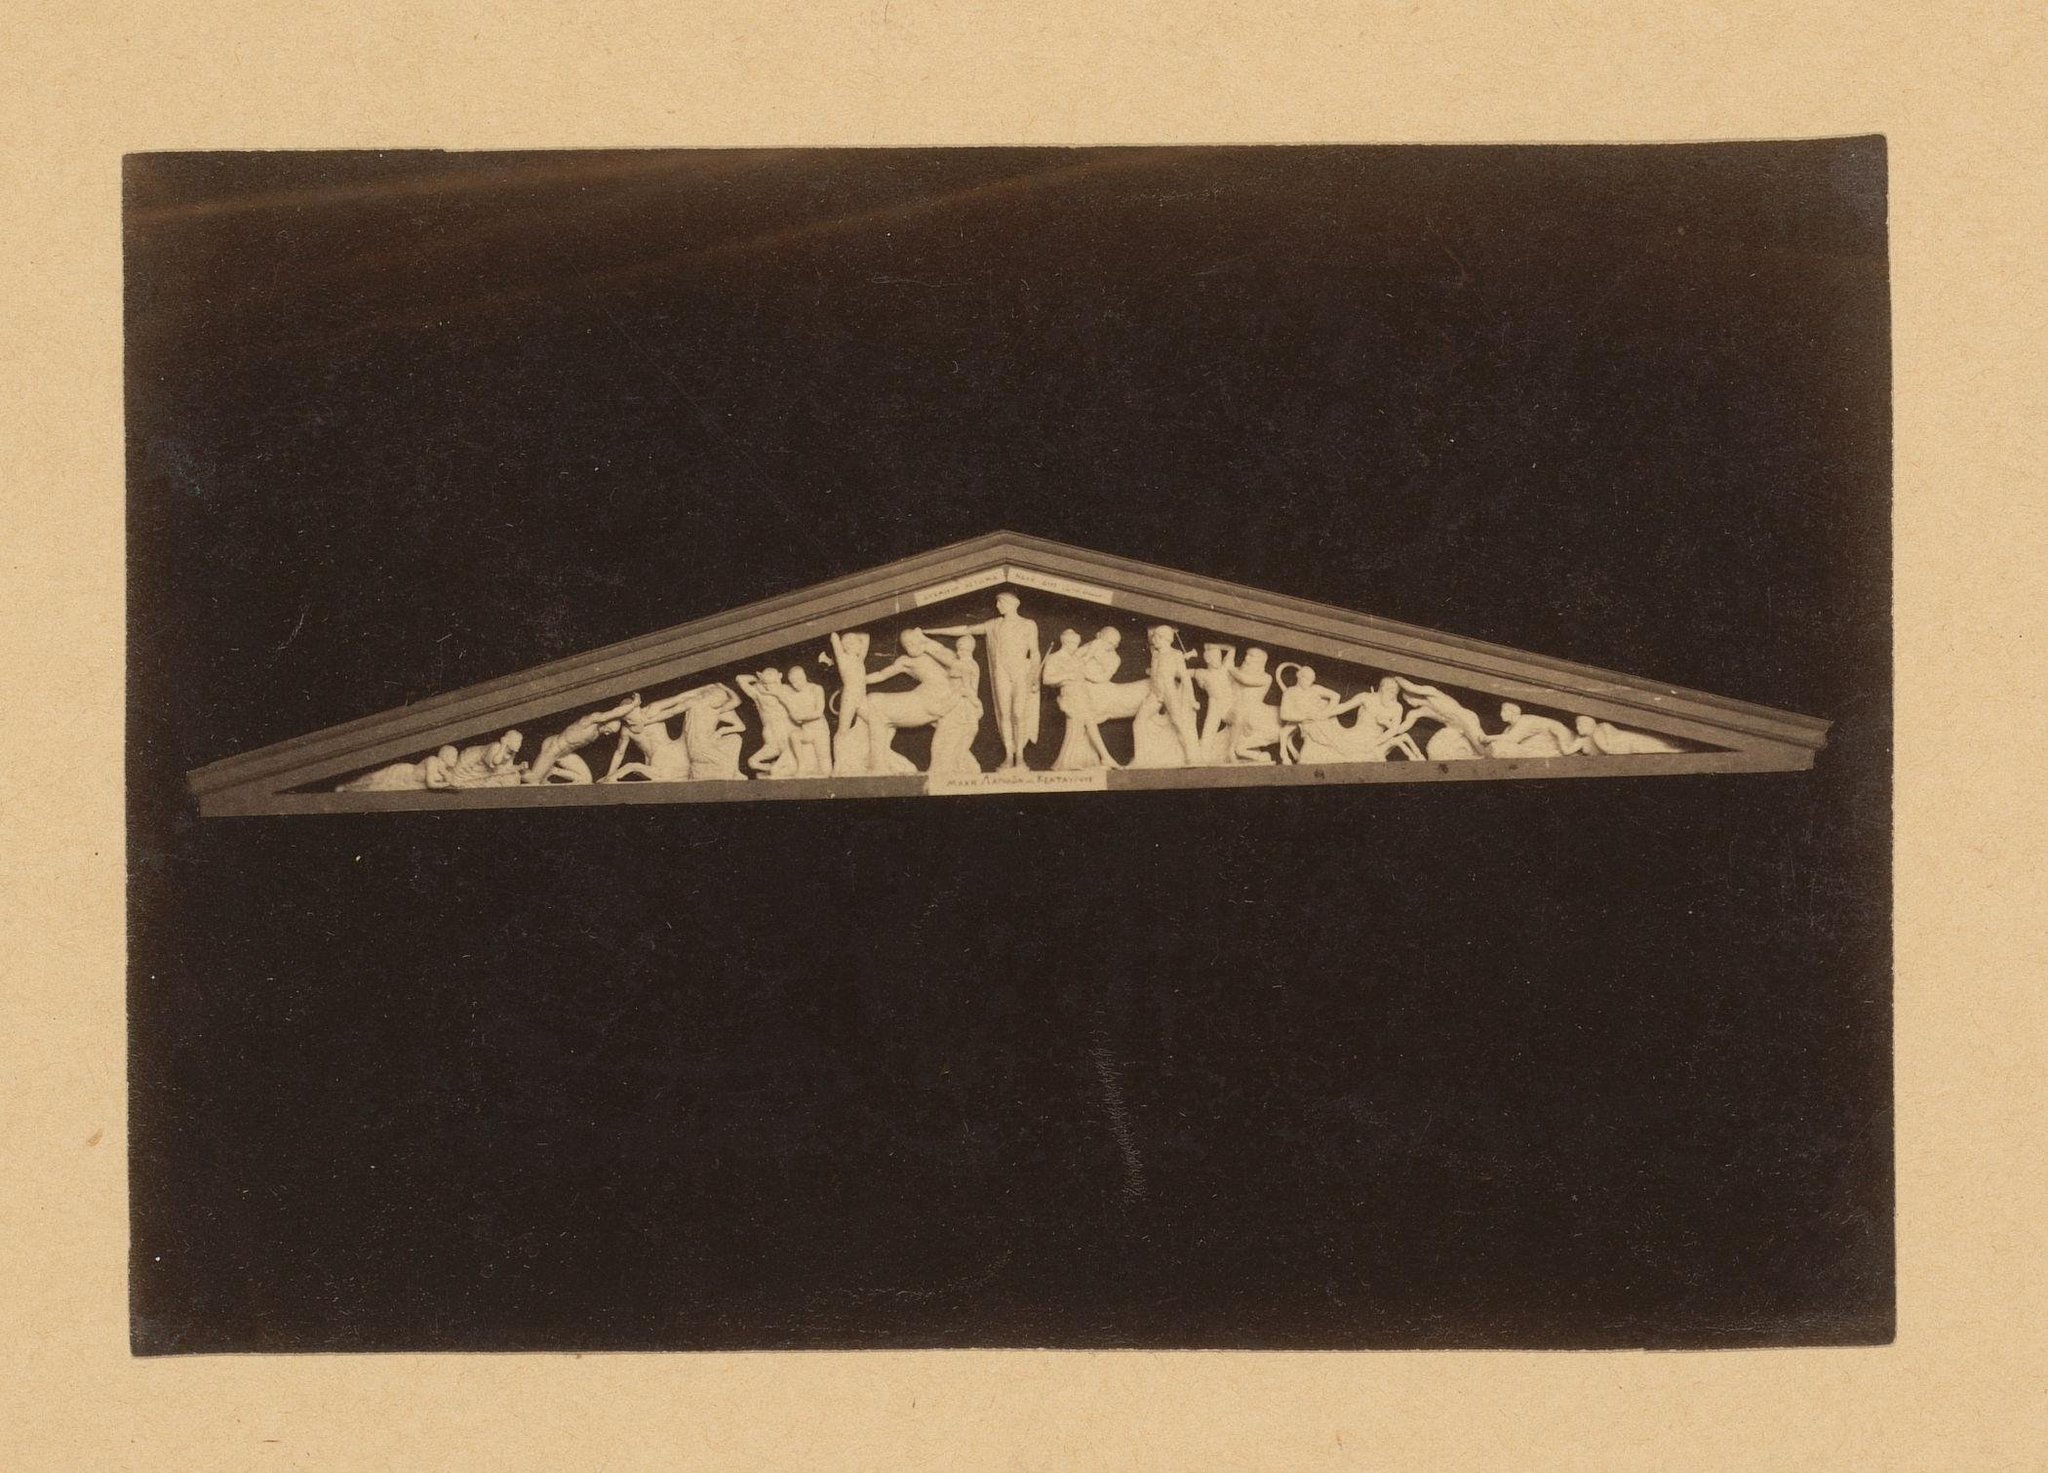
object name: photograph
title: Model van het timpaan van de tempel van Zeus te Olympia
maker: Anonymous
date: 1890-1895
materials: cardboard, paper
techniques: albumen print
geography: olympia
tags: piece of sculpture, reproduction of a piece of sculpture, temple, shrine ~ greek religion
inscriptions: check stamp: ‘Bristol/ L.M.’, stamp: ‘Gemeentelijke bibliotheek/ Rotterdam’, title: ‘G 55. Gevelveld van den tempel van Zeus. Olympia./ (Photo naar een herstelde gips reproductie).’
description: Onderdeel van een groep door fotograaf Richard Polak op reis verzamelde foto’s. Deze foto is samen met andere op zijn reizen verzamelde foto's tentoongesteld bij de Rotterdamsche Kunstkring (1895), Arti en Amicitiae te Amsterdam (1897-1898?) en Societeit 't Collegie te Kampen (datum vooralsnog onbekend).